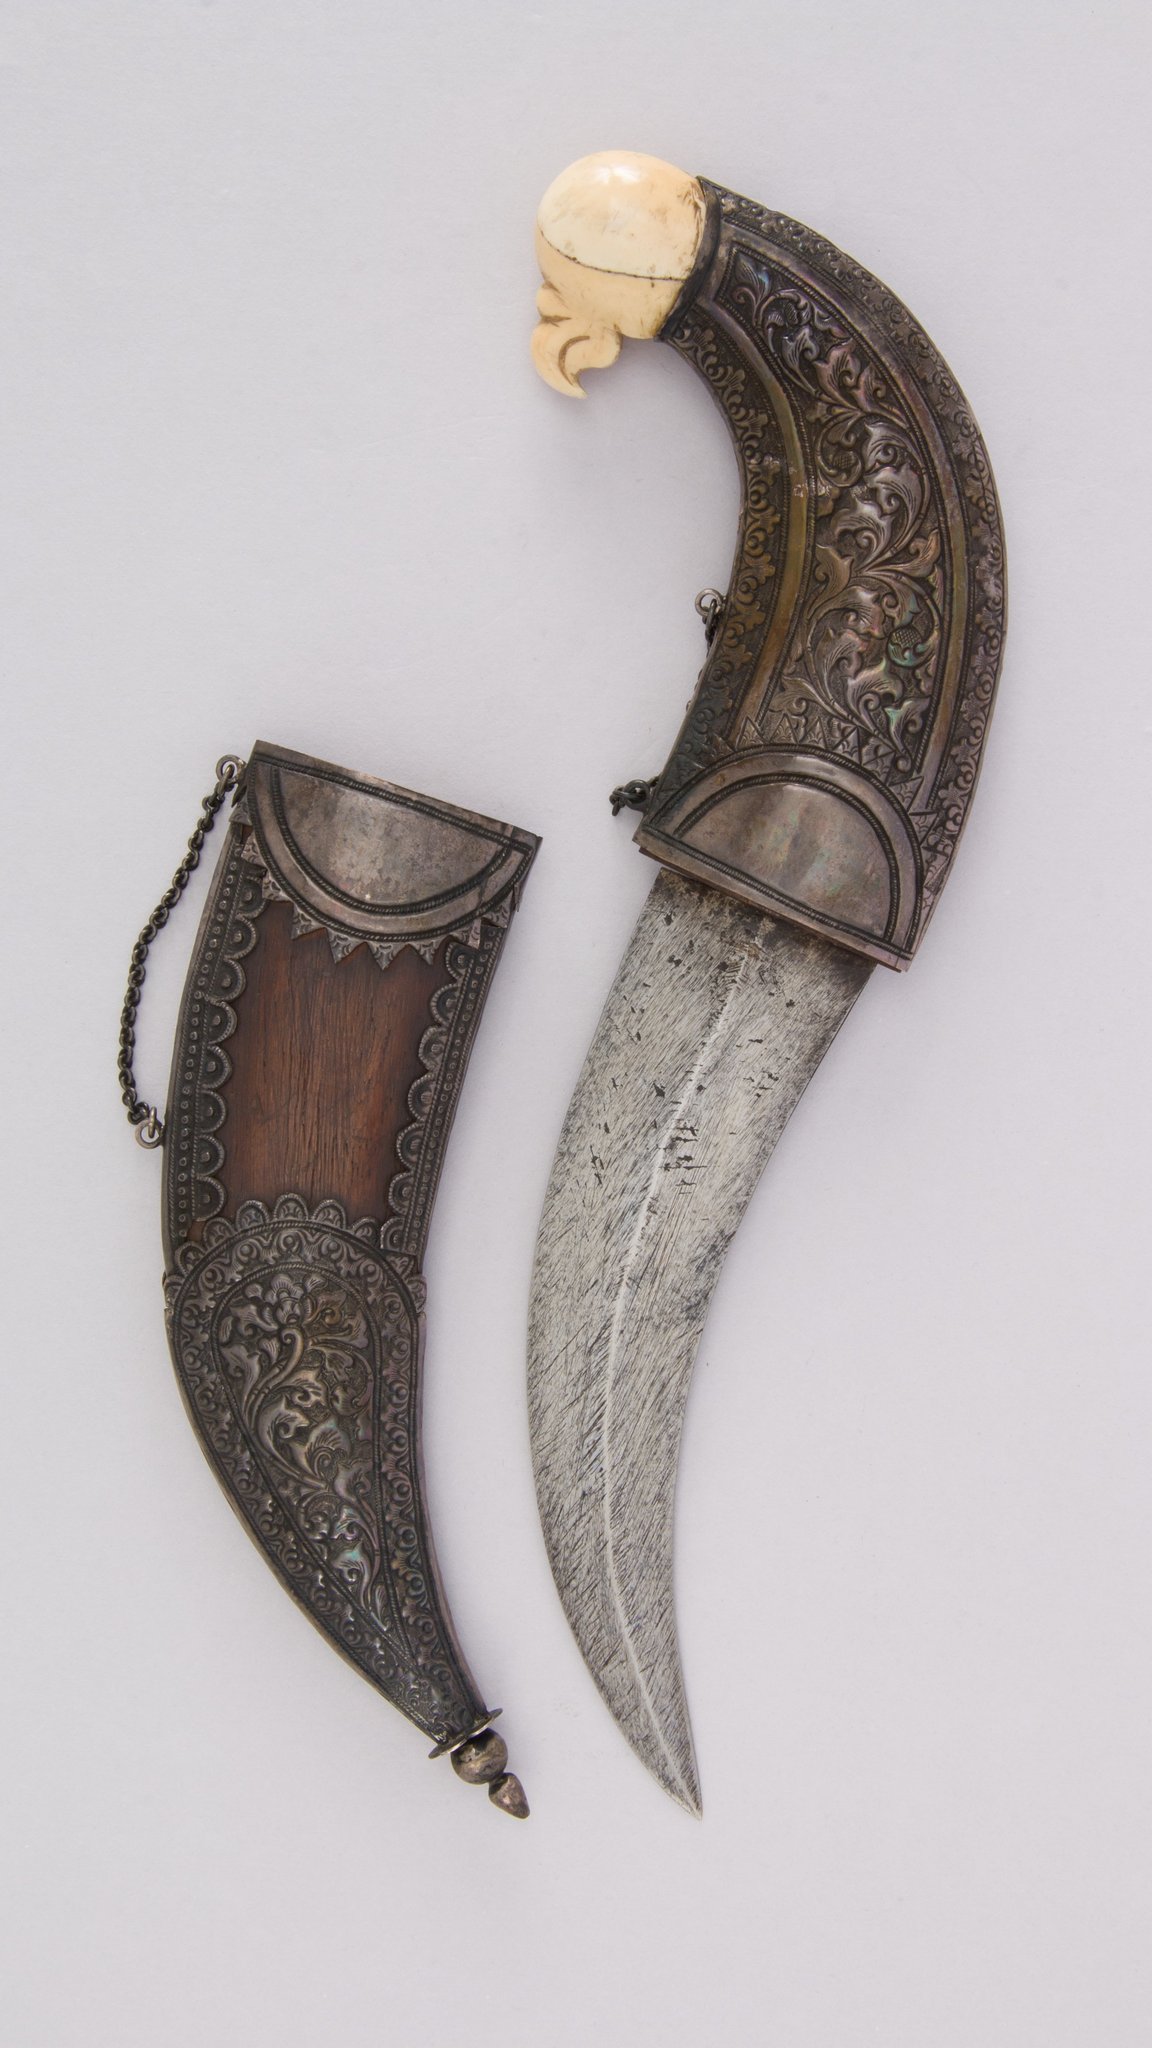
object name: dagger jambiya with sheath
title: Dagger (Jambiya) with Sheath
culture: indian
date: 1801-1900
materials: ivory, silver, steel, wood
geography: india